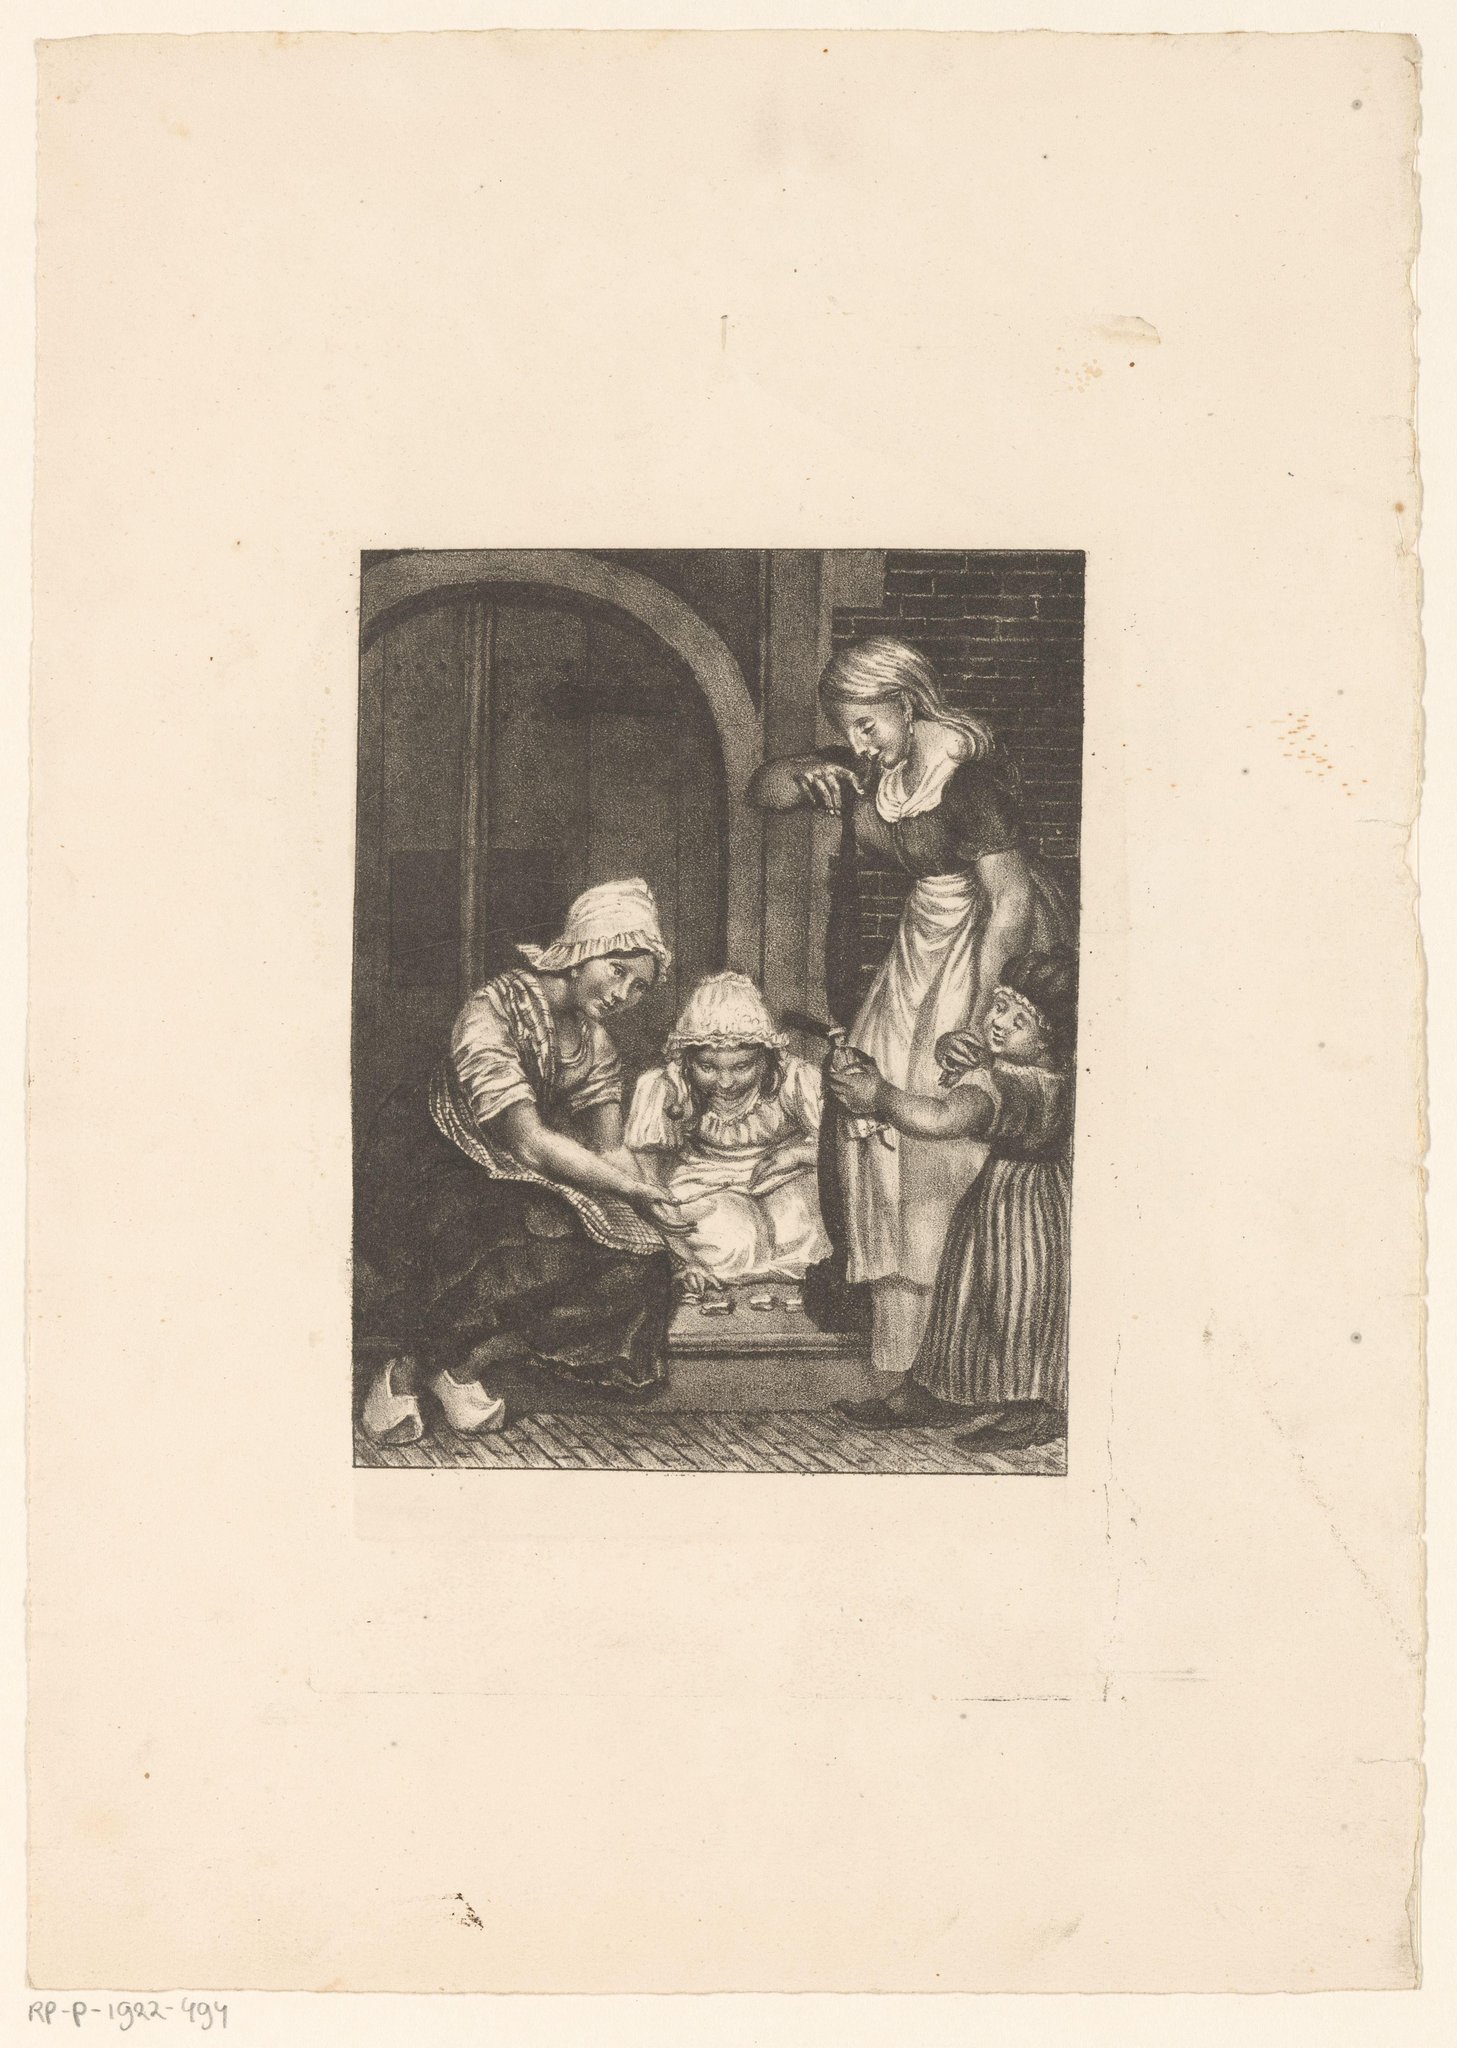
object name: print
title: Bikkelende kinderen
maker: Anonymous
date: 1809-1899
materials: paper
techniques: lithograph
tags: girl (child between toddler and youth), games using special objects (marbles, top, hoop, etc.)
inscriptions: collector's mark: Lugt 2233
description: Vier meisjes van uiteenlopende leeftijd staan en zitten op de grond. In het midden liggen de kleine botten die, om de beurt, door de kinderen omhoog worden gegooid. Het jongste meisje heeft een pop in haar hand.